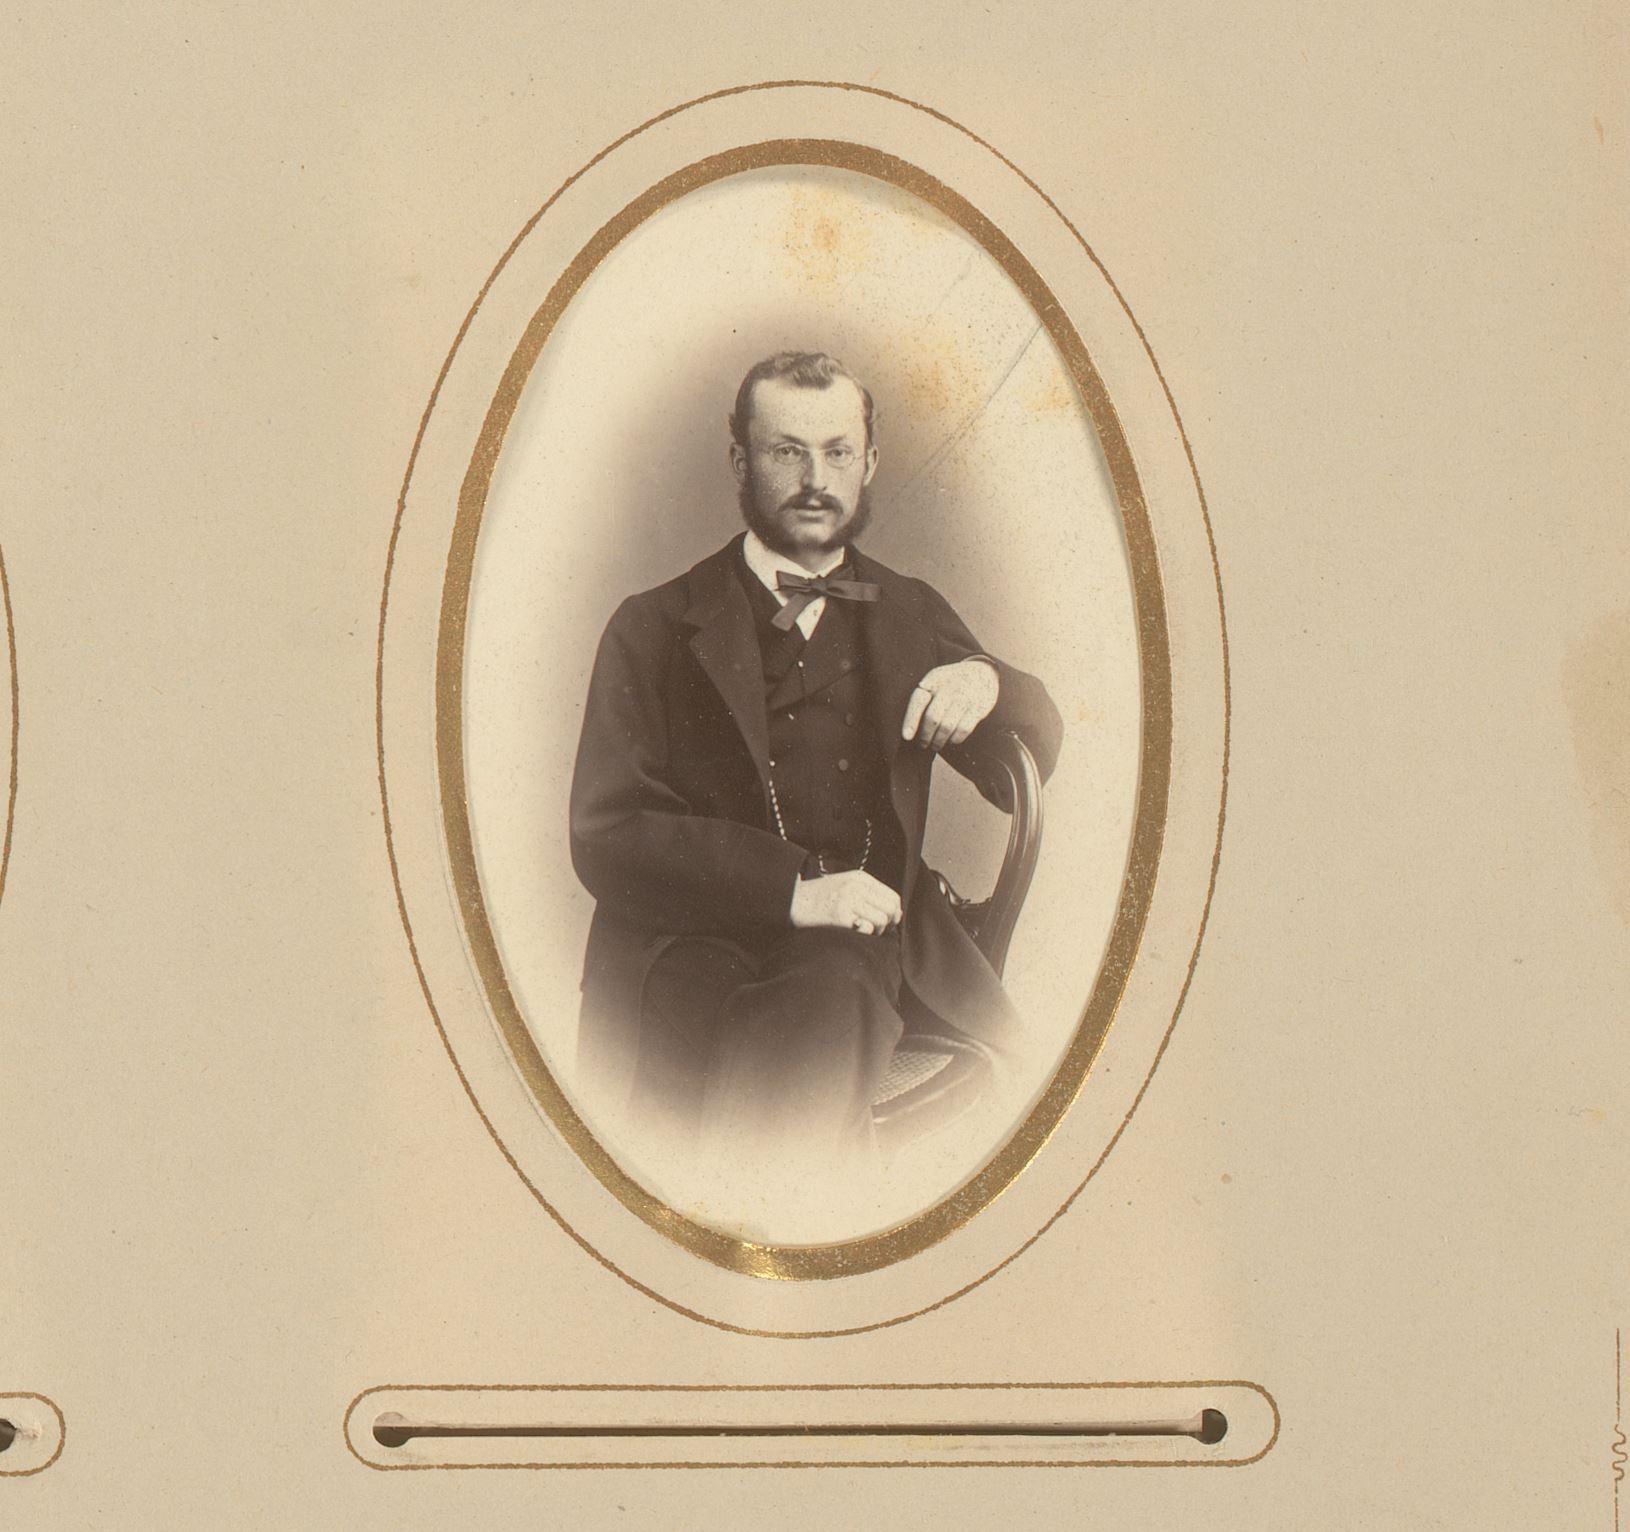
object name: carte de visite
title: Portret van een man met bril, snor en ringbaard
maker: f. springmeier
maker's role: fotograaf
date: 1850-1900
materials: cardboard, photographic support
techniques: albumen print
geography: elberfeld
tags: eyeglasses, spectacles, historical persons, beard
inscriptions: inscription: ‘F. Springmeier/ PHOTOGRAPH/ Elberfeld/ Herzogstrasse, No. 4.’